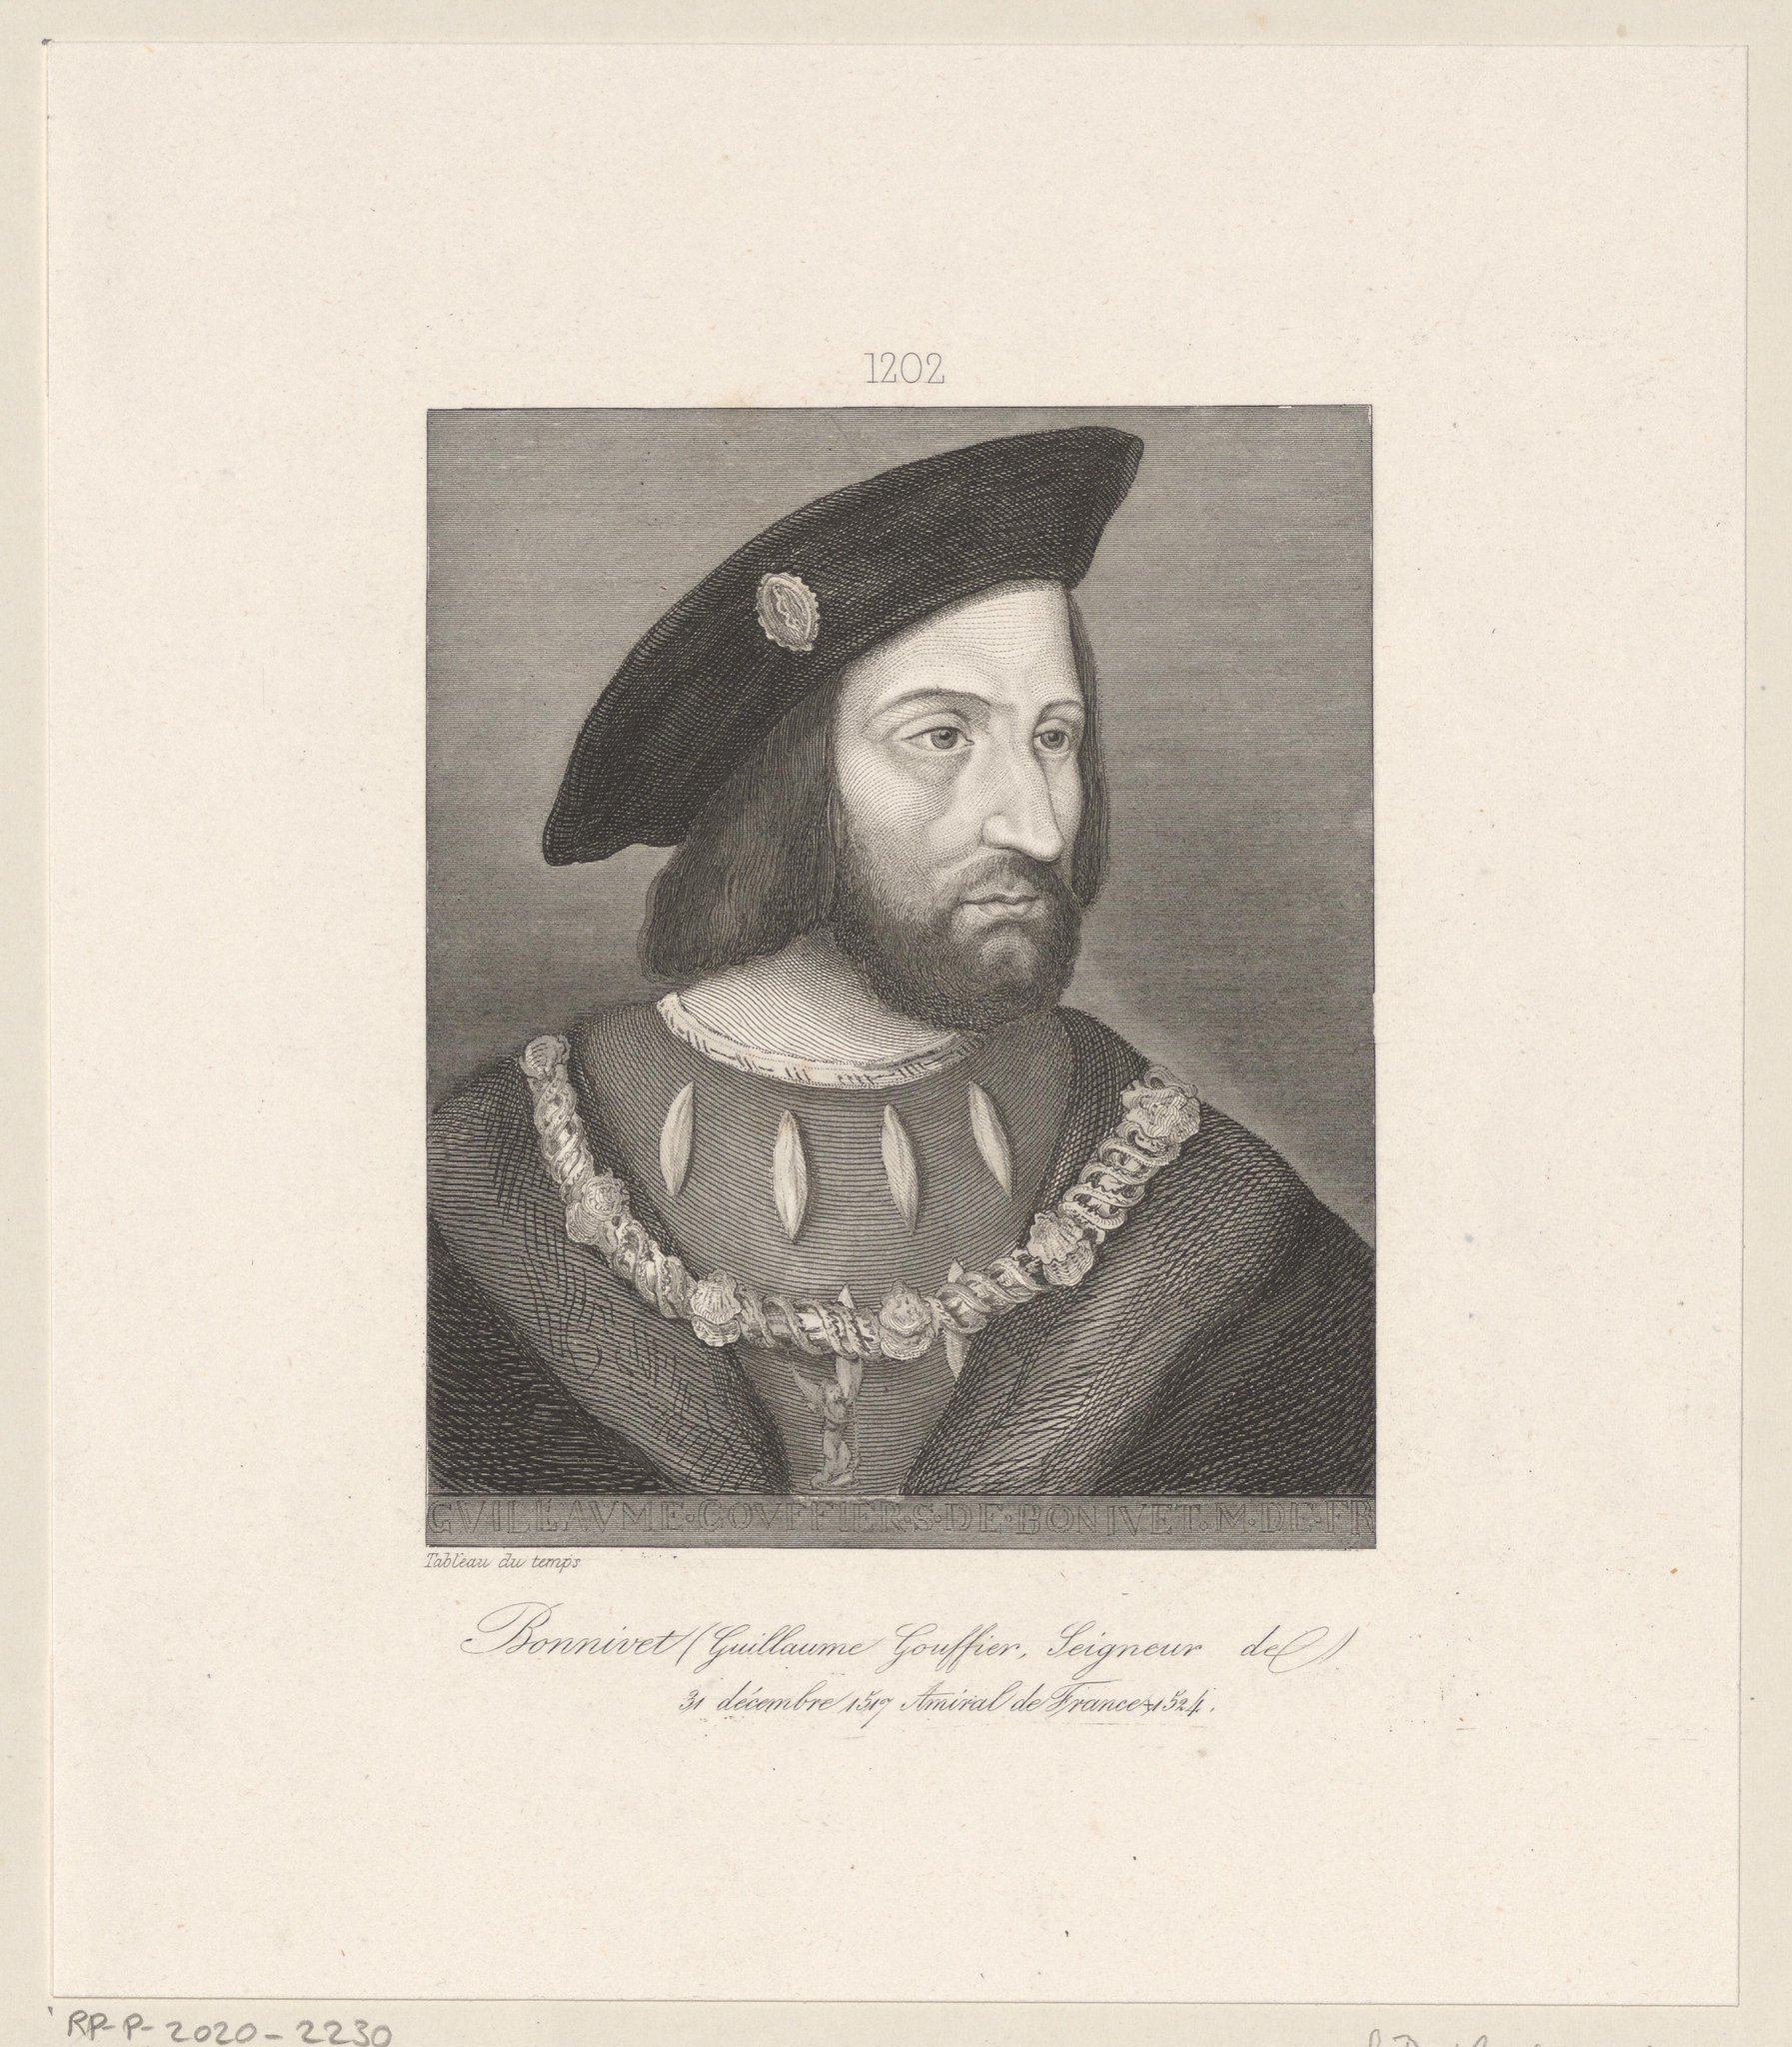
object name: print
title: Portret van Guillaume Gouffier de Bonnivet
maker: Anonymous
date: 1800-1849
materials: paper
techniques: engraving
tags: historical persons, commander-in-chief, admiral